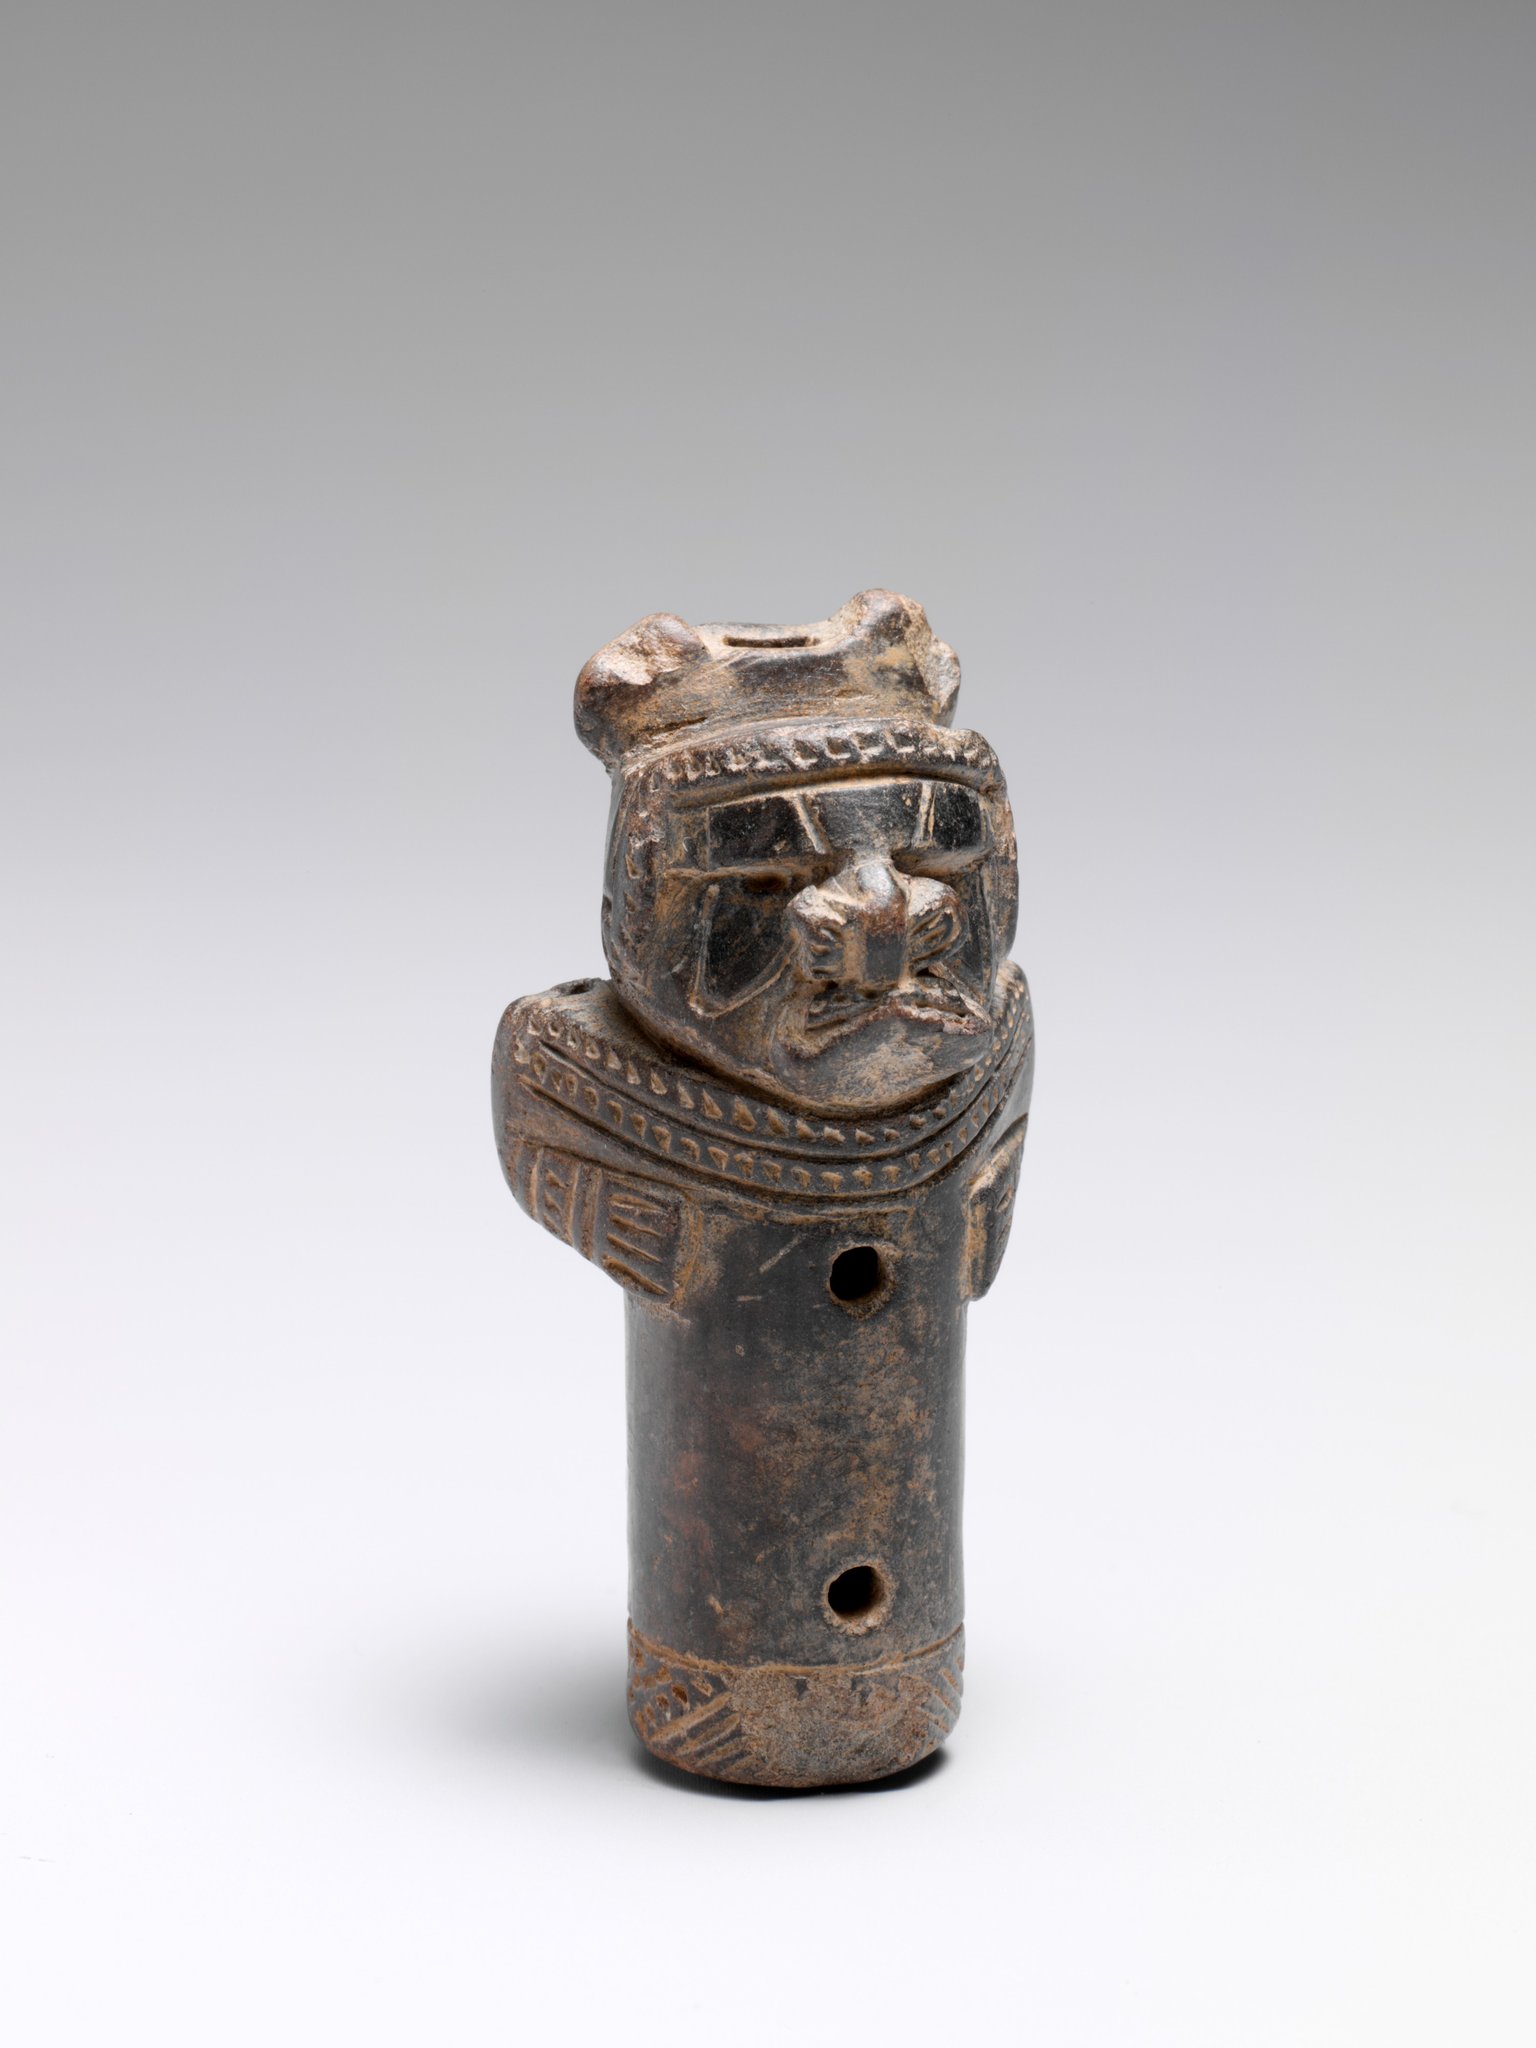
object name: flute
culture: tairona people or la aguja style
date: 1300-1500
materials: ceramic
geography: colombia